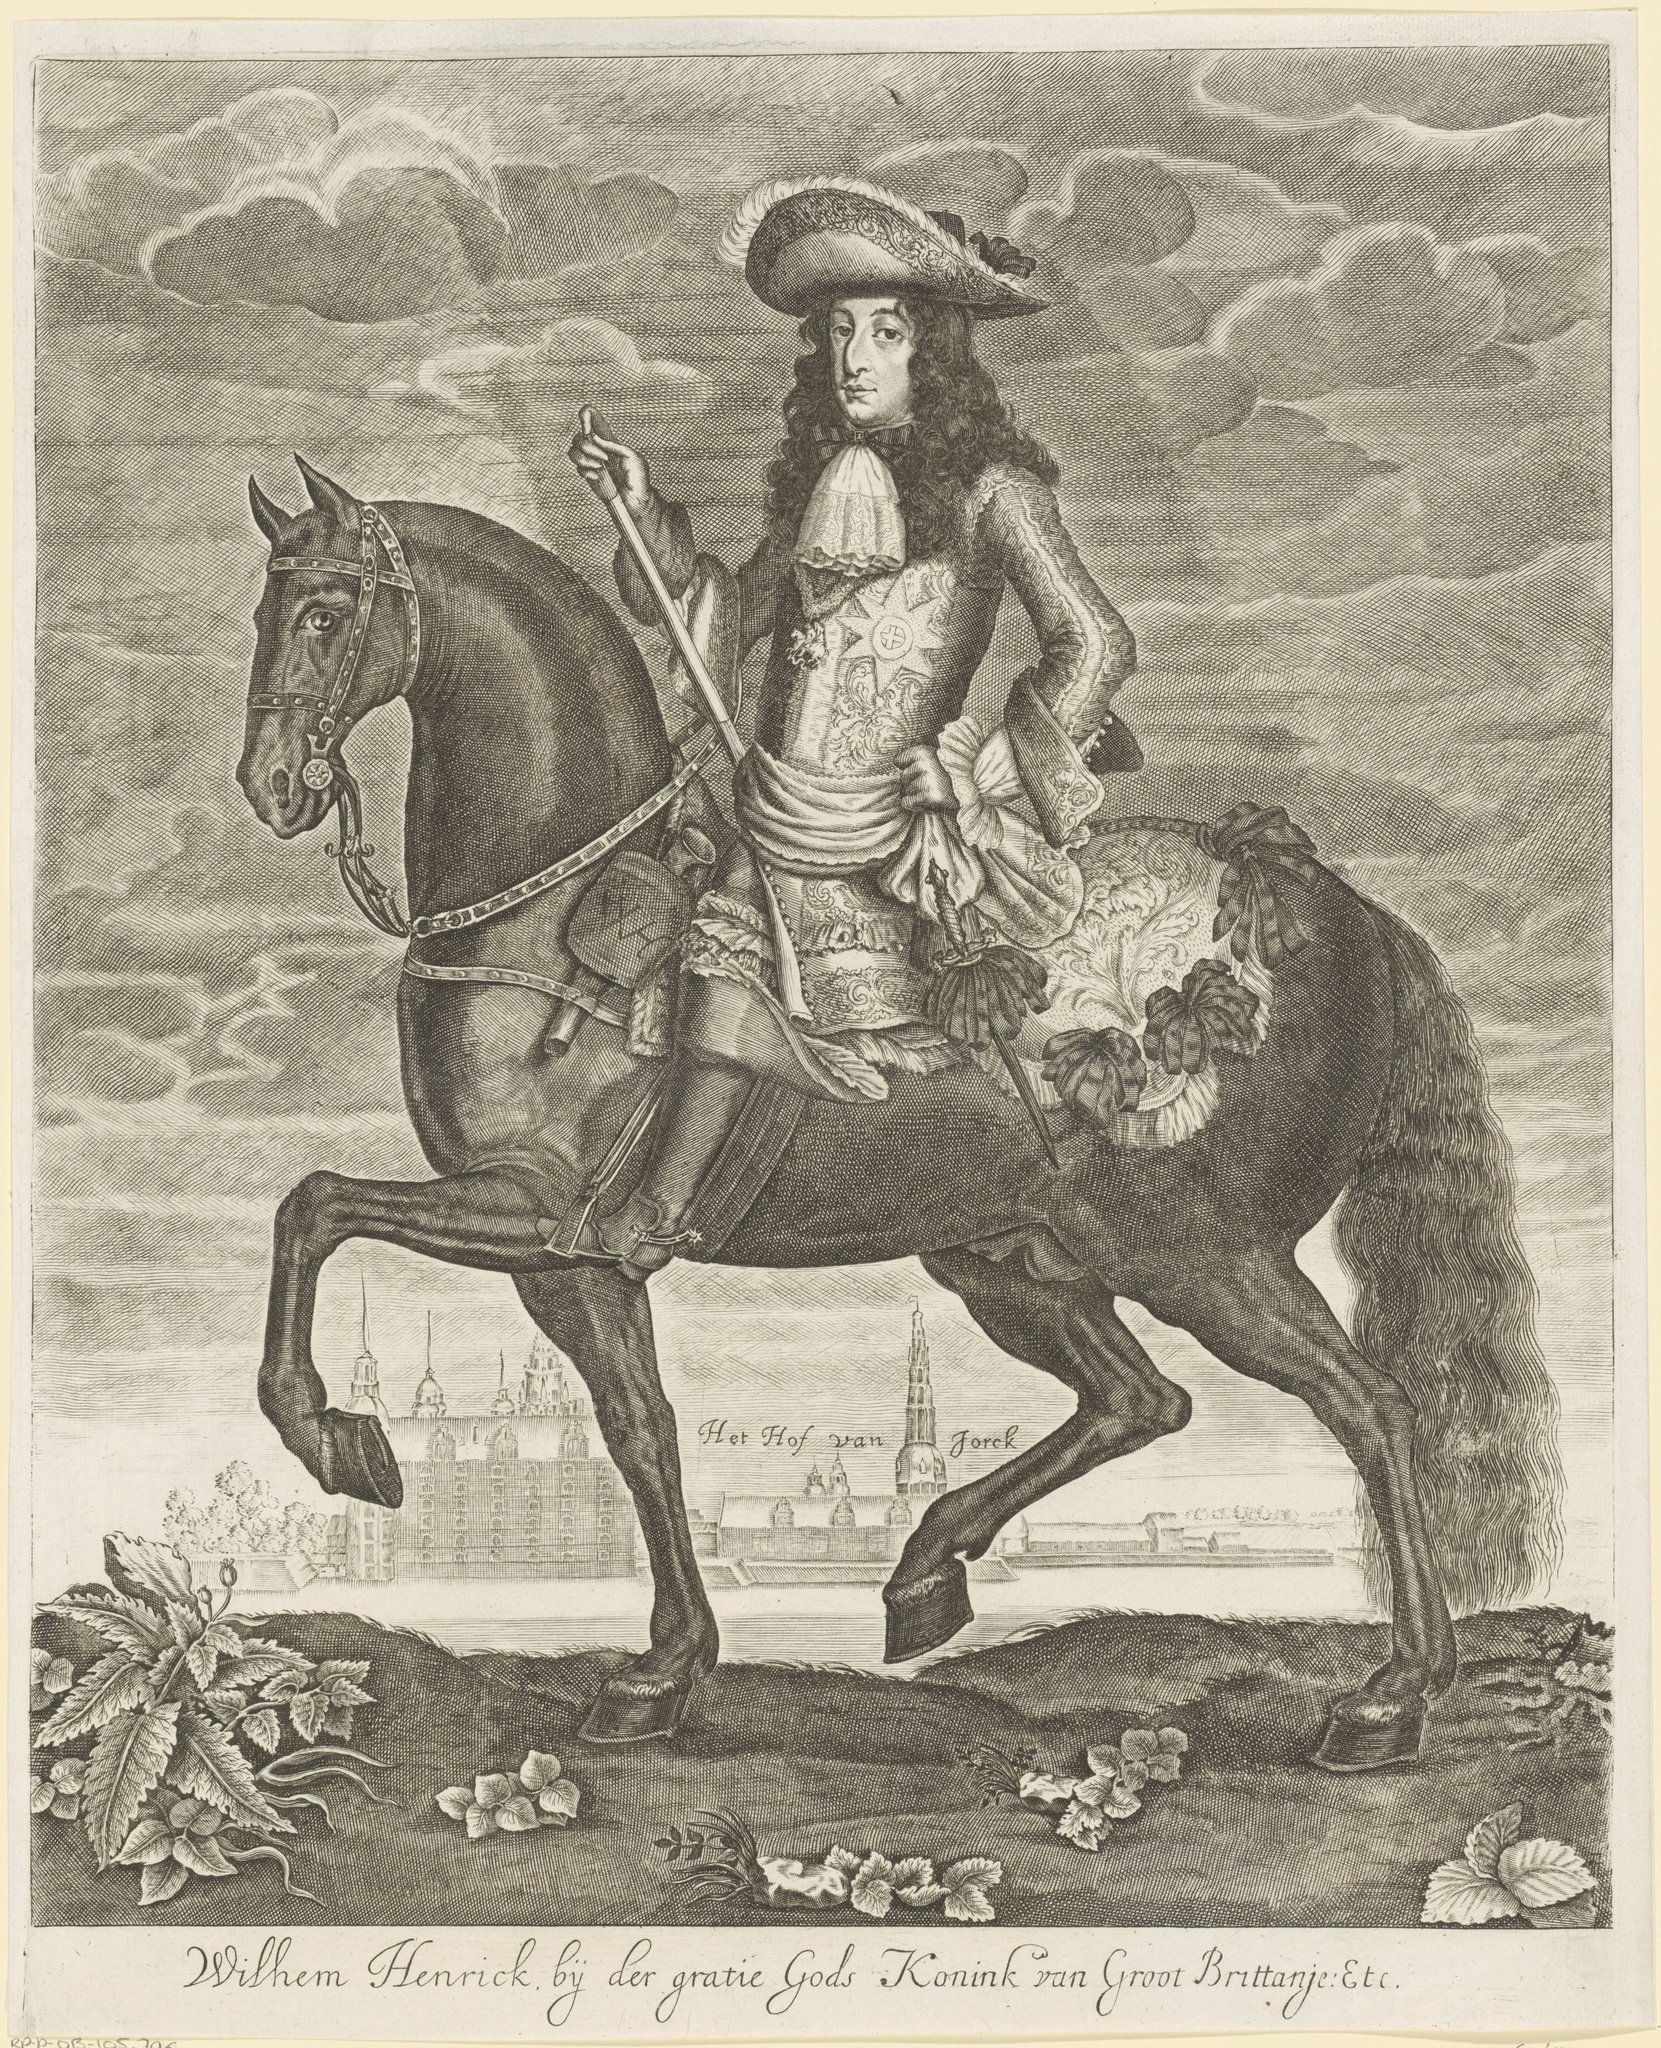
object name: print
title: Ruiterportret van Willem III, prins van Oranje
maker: Anonymous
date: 1688-1749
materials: paper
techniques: engraving, etching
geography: low countries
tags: the hague, william iii (prince of orange and king of england, scotland, and ireland), knighthood order (garter) - insignia of a knighthood order, e.g.: badge, chain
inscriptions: collector's mark: Lugt 963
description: De hier vermelde titel verwijst naar de hoogst verkregen titel van de geportretteerde, niet per se naar de titel die de geportretteerde op deze voorstelling draagt.